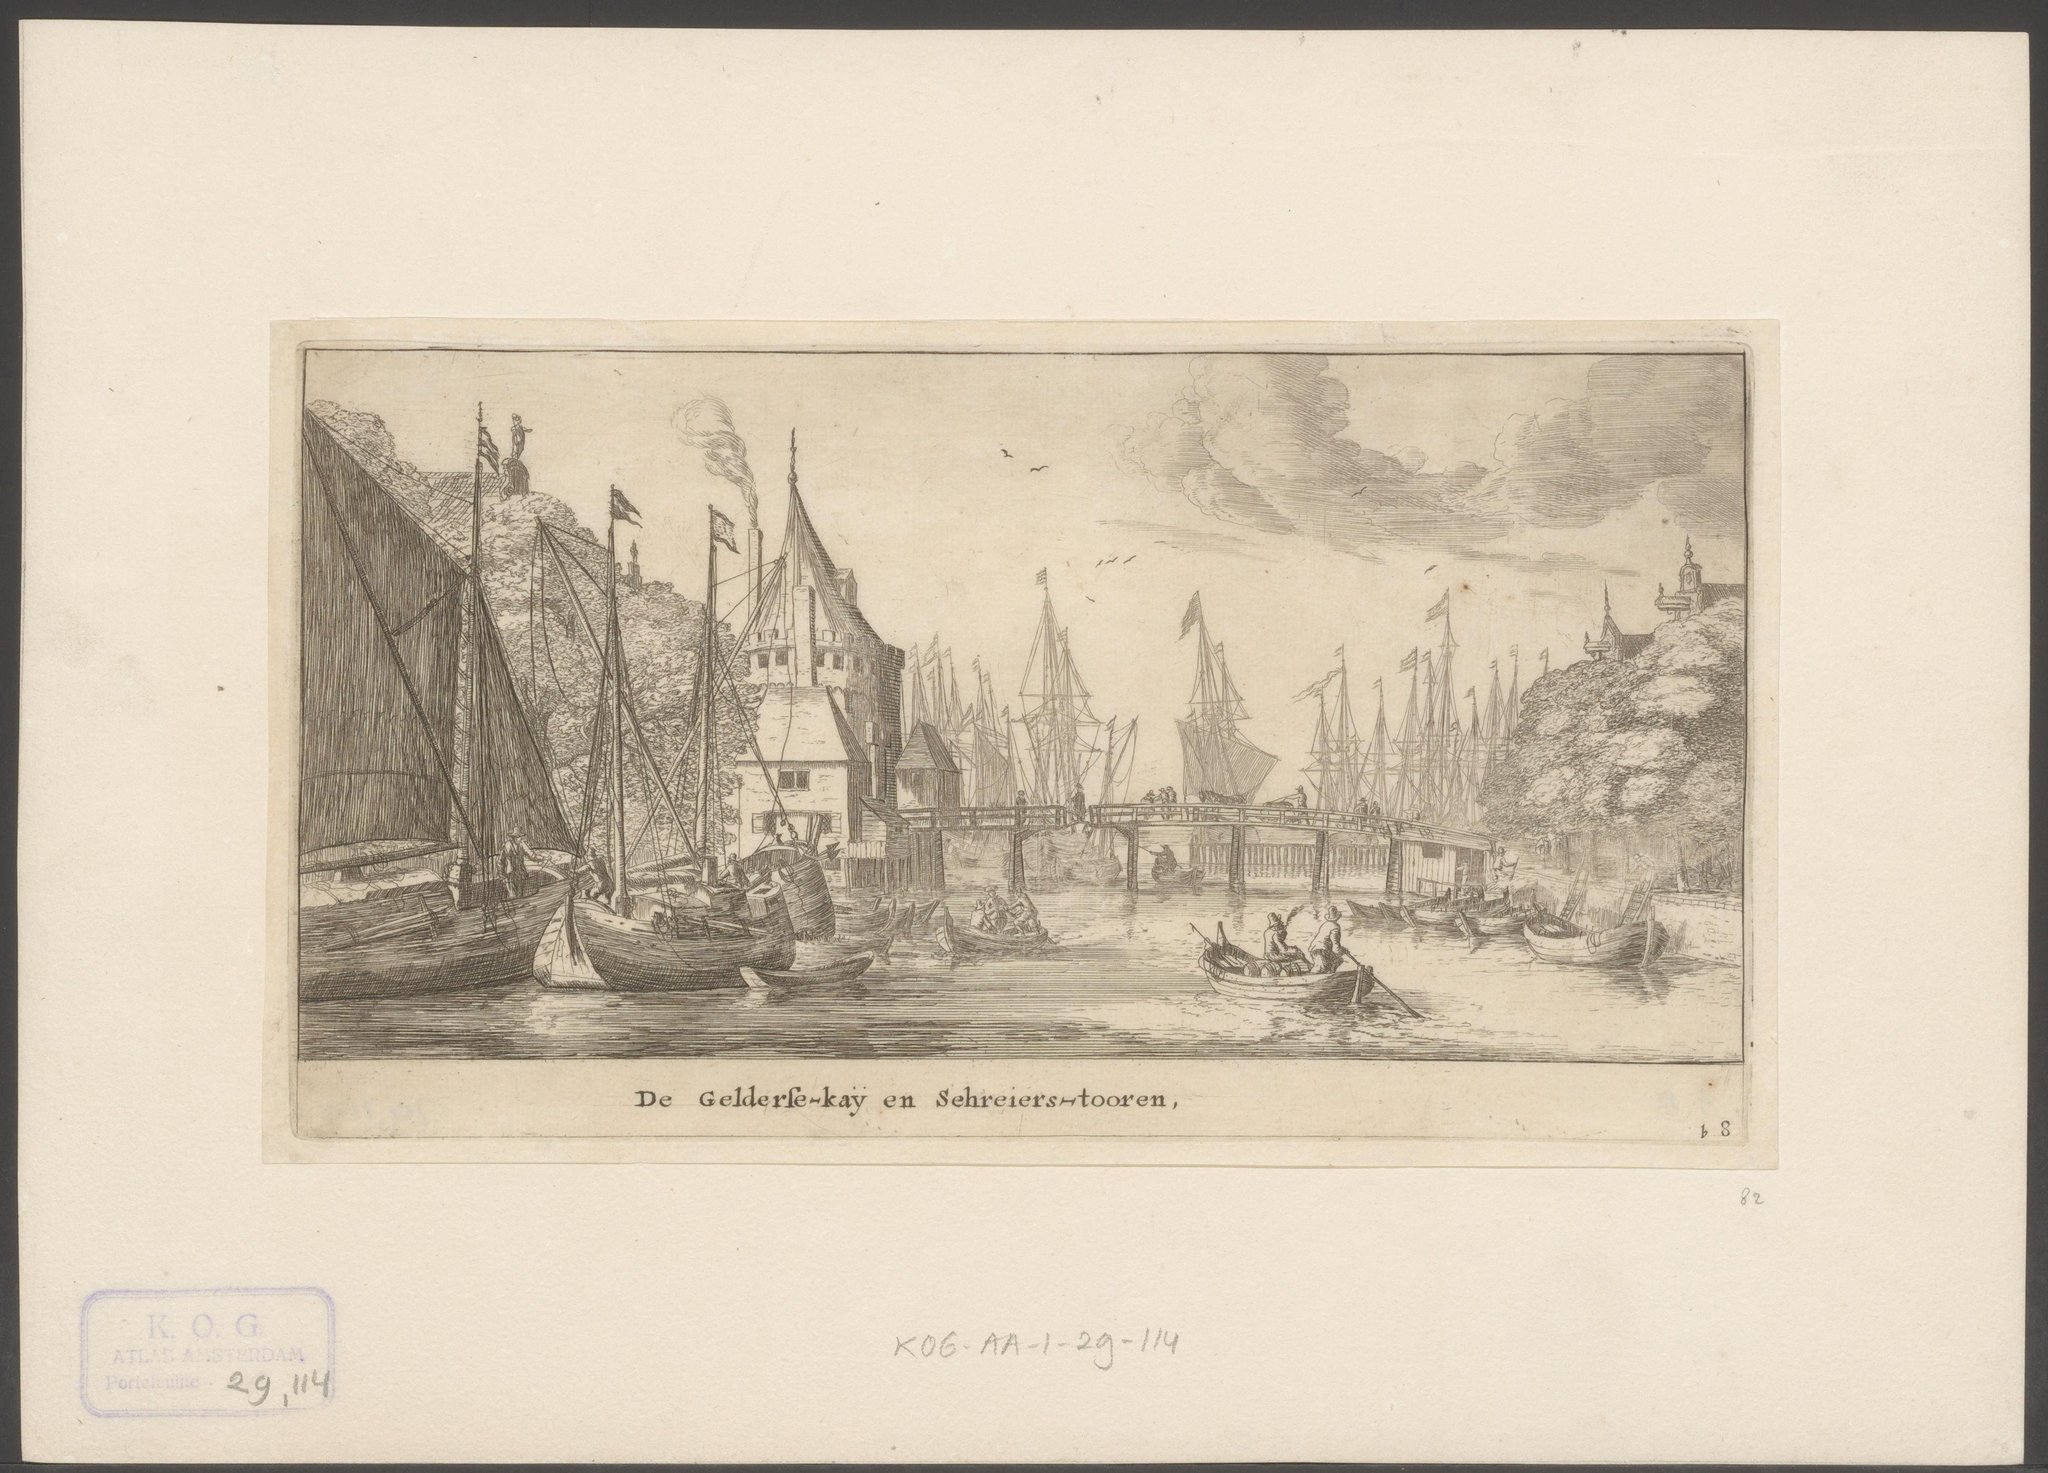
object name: print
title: Verschillende schepen en stadsgezichten van Amsterdam, tweede deel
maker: reinier nooms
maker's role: draughtsman, painter, print maker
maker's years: 1623-1664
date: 1652-1693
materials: paper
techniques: engraving, etching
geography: amsterdam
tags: bridge in city across river, canal, etc. (+ city(-scape) with figures, staffage), sailing-ship, sailing-boat, towers ~ fortified city, rowing-boat, canoe, etc.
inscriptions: collector's mark: Lugt 1628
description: Prent uit serie mogelijk uitgegeven door Cornelis Danckerts (I), Dancker Danckerts, Clement de Jonghe of Johannes de Ram. Het is evenwel niet na te gaan uit welke uitgave de huidige prent komt.